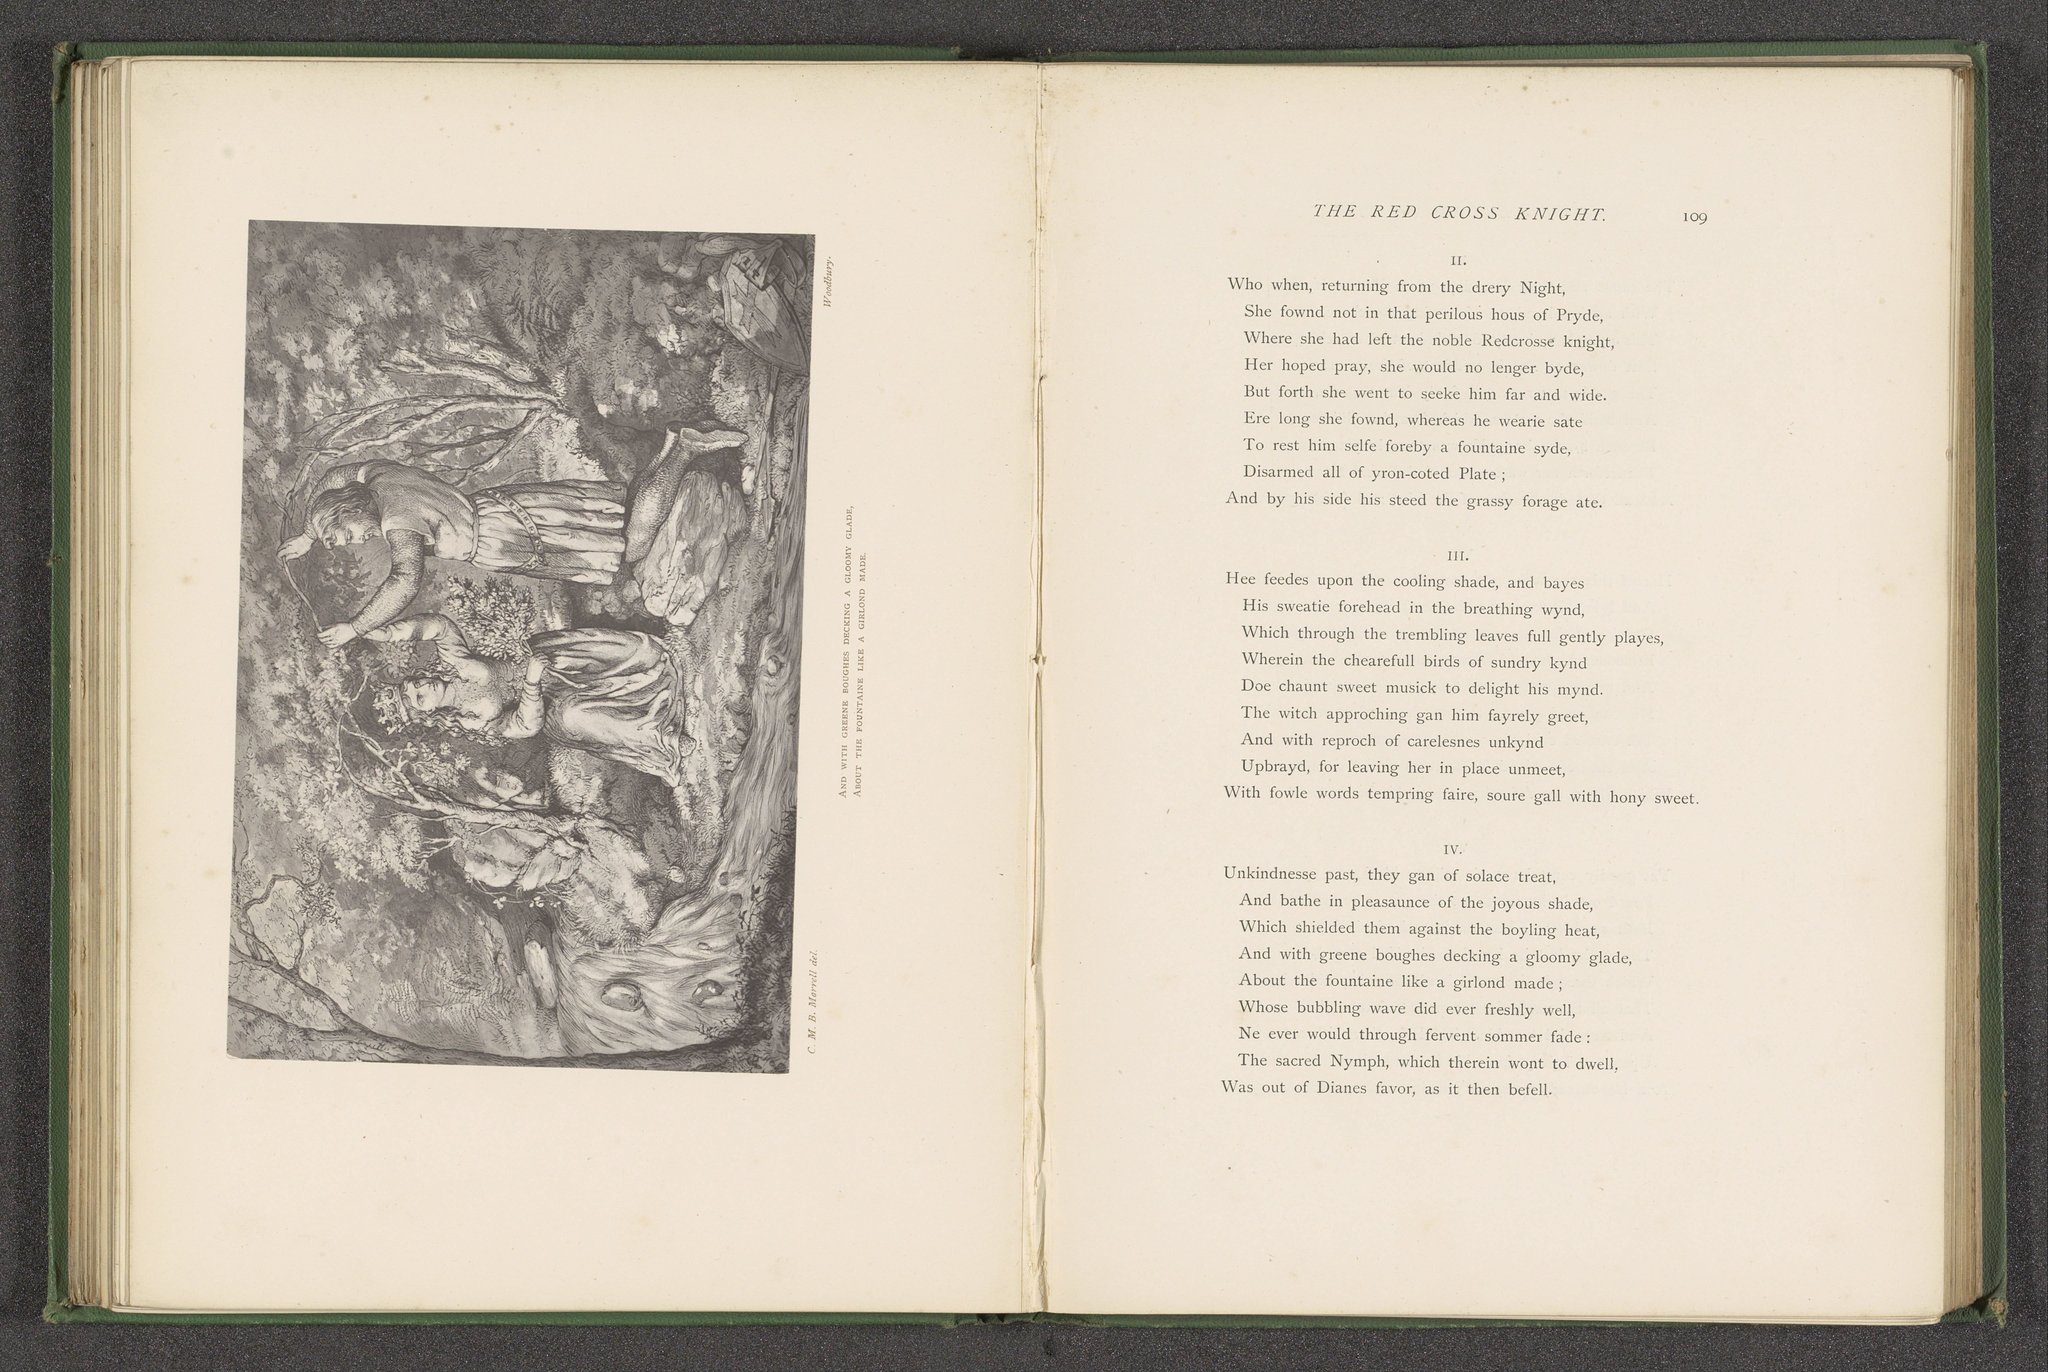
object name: reproduction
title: Fotoreproductie van een tekening, voorstellende Redcrosse en Duessa naast een beek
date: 1861-1871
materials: paper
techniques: woodburytype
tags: brook, sitting on the ground - aa - female human figure, knight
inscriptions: inscription: ‘And with greene boughes (...) like a girlond made.’